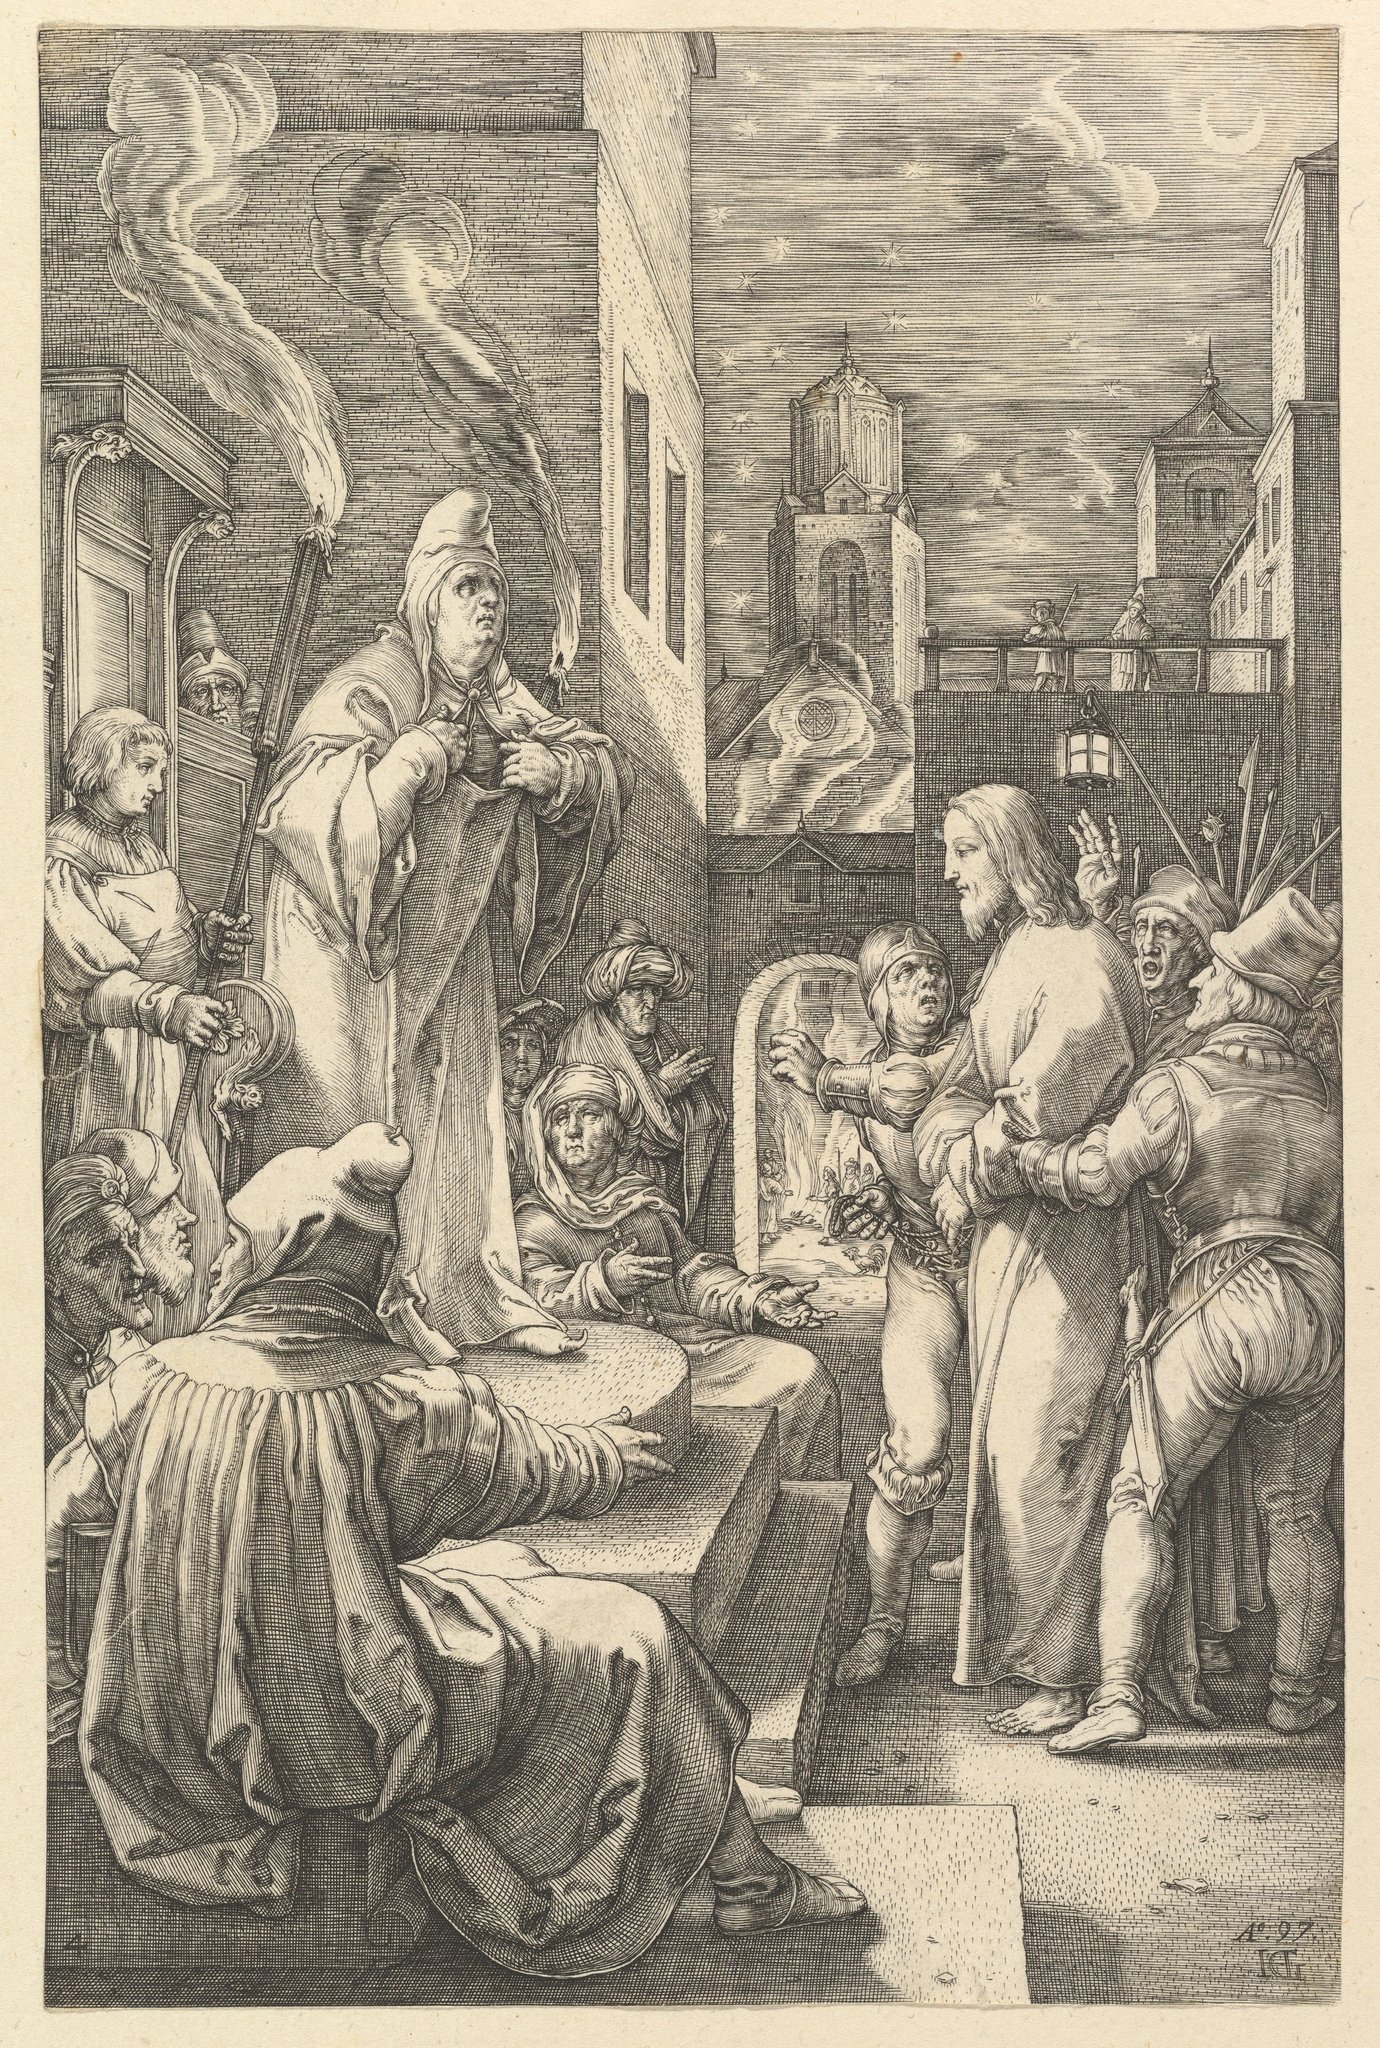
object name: print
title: Christ before Caiphas, from "The Passion of Christ"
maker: hendrick goltzius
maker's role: artist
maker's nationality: netherlandish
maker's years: 1558-1617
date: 1597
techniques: engraving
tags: men,christ